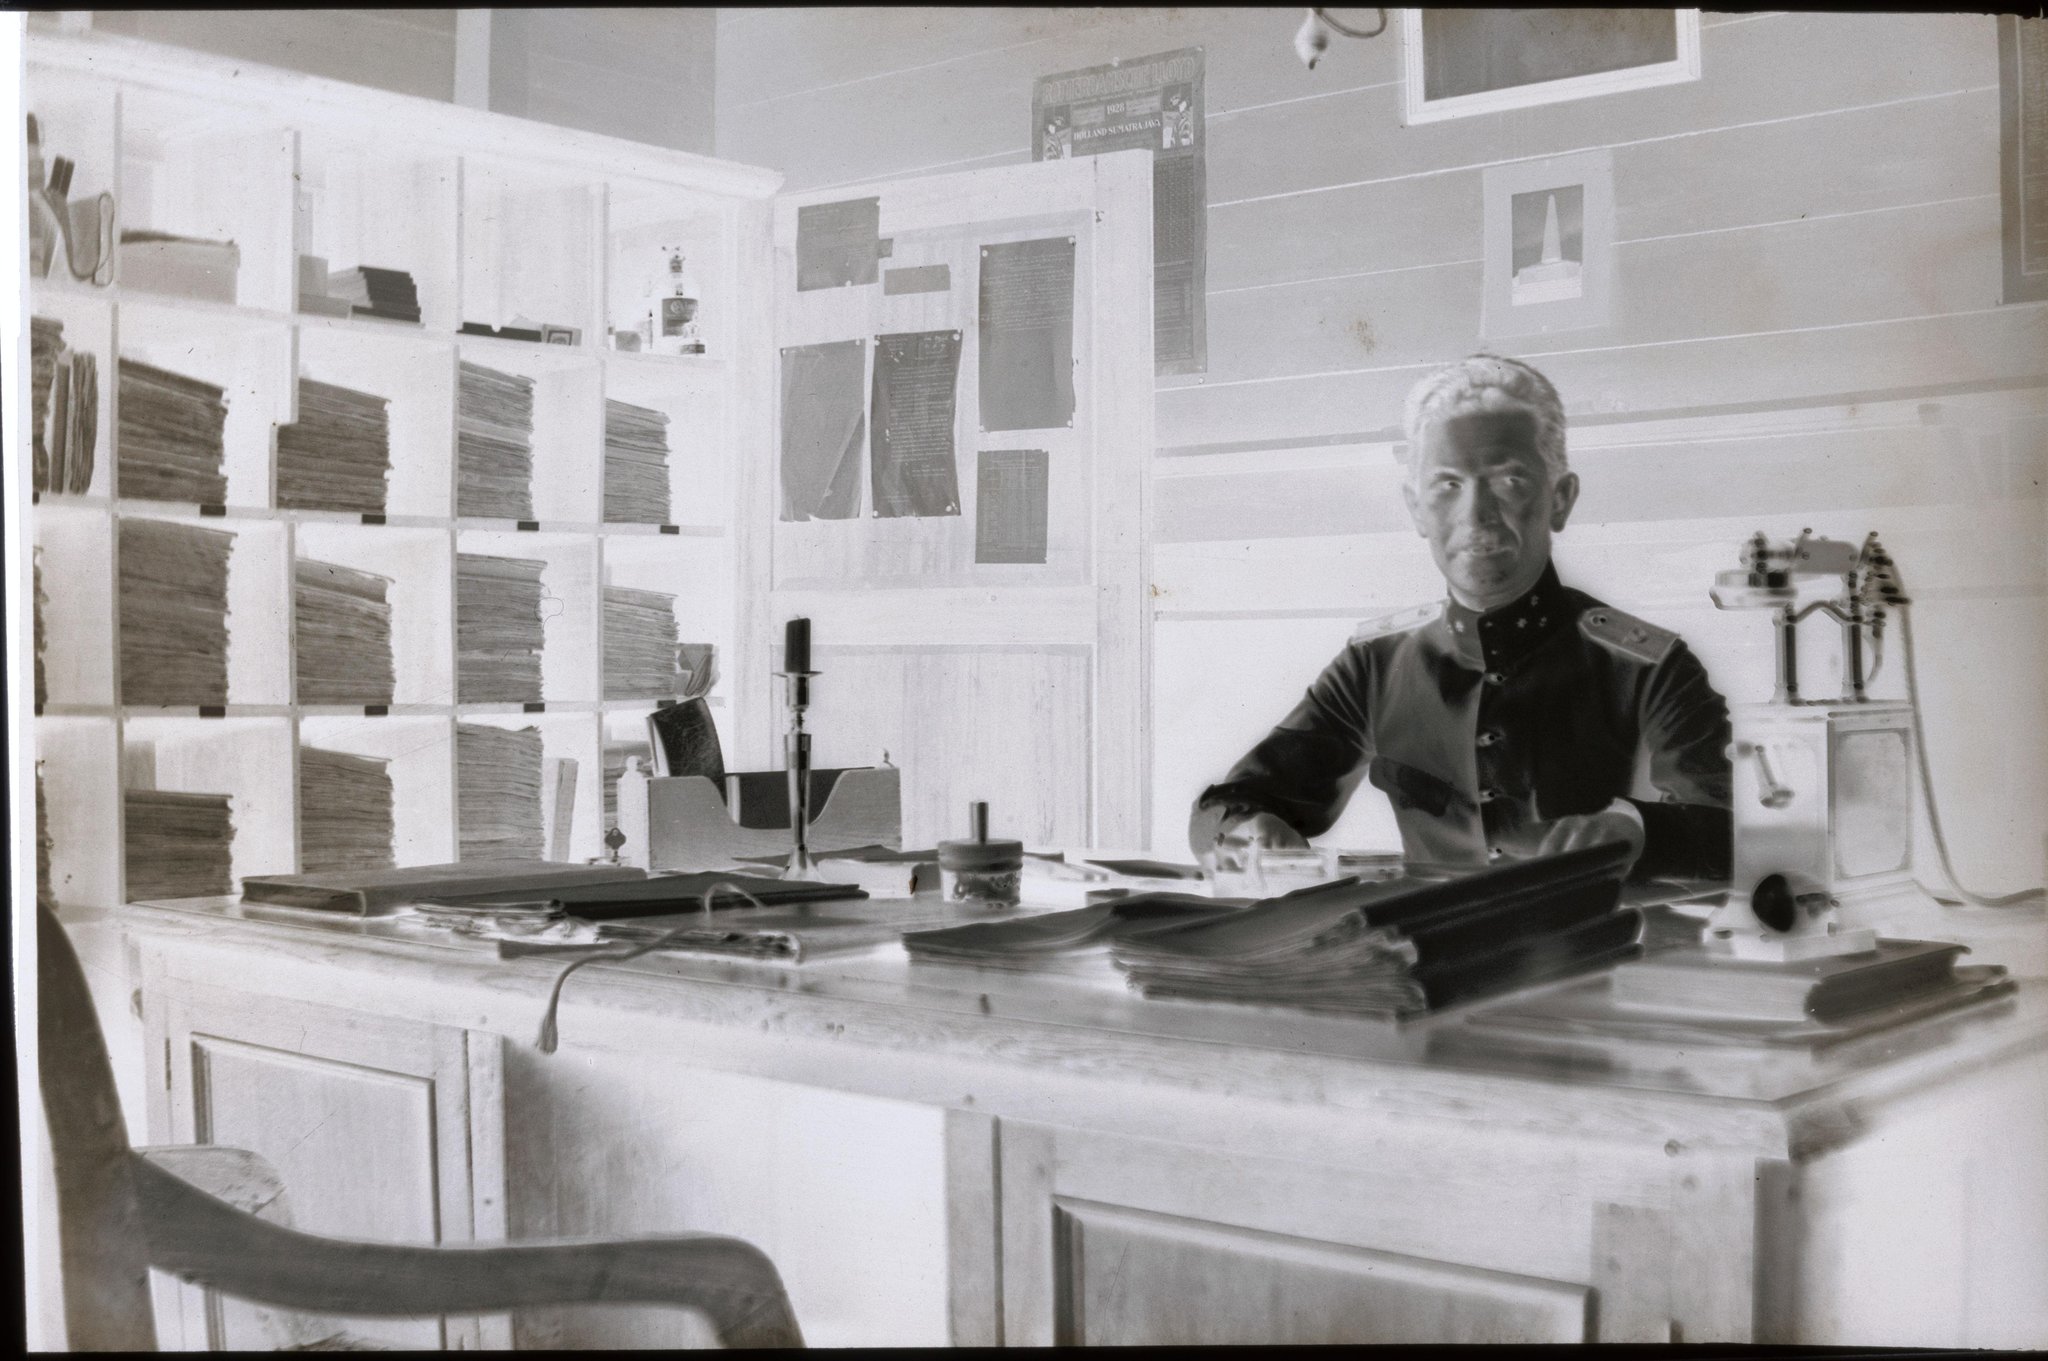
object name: negative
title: Man in uniform zittend achter zijn bureau in Padang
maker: Anonymous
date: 1928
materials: film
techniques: gelatin silver negative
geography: padang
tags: office (~ administration), (military) uniforms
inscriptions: number: ‘1’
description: Onderdeel van Kodak negatievenalbum met 35 foto's van een familie in Nederlands-Indië.